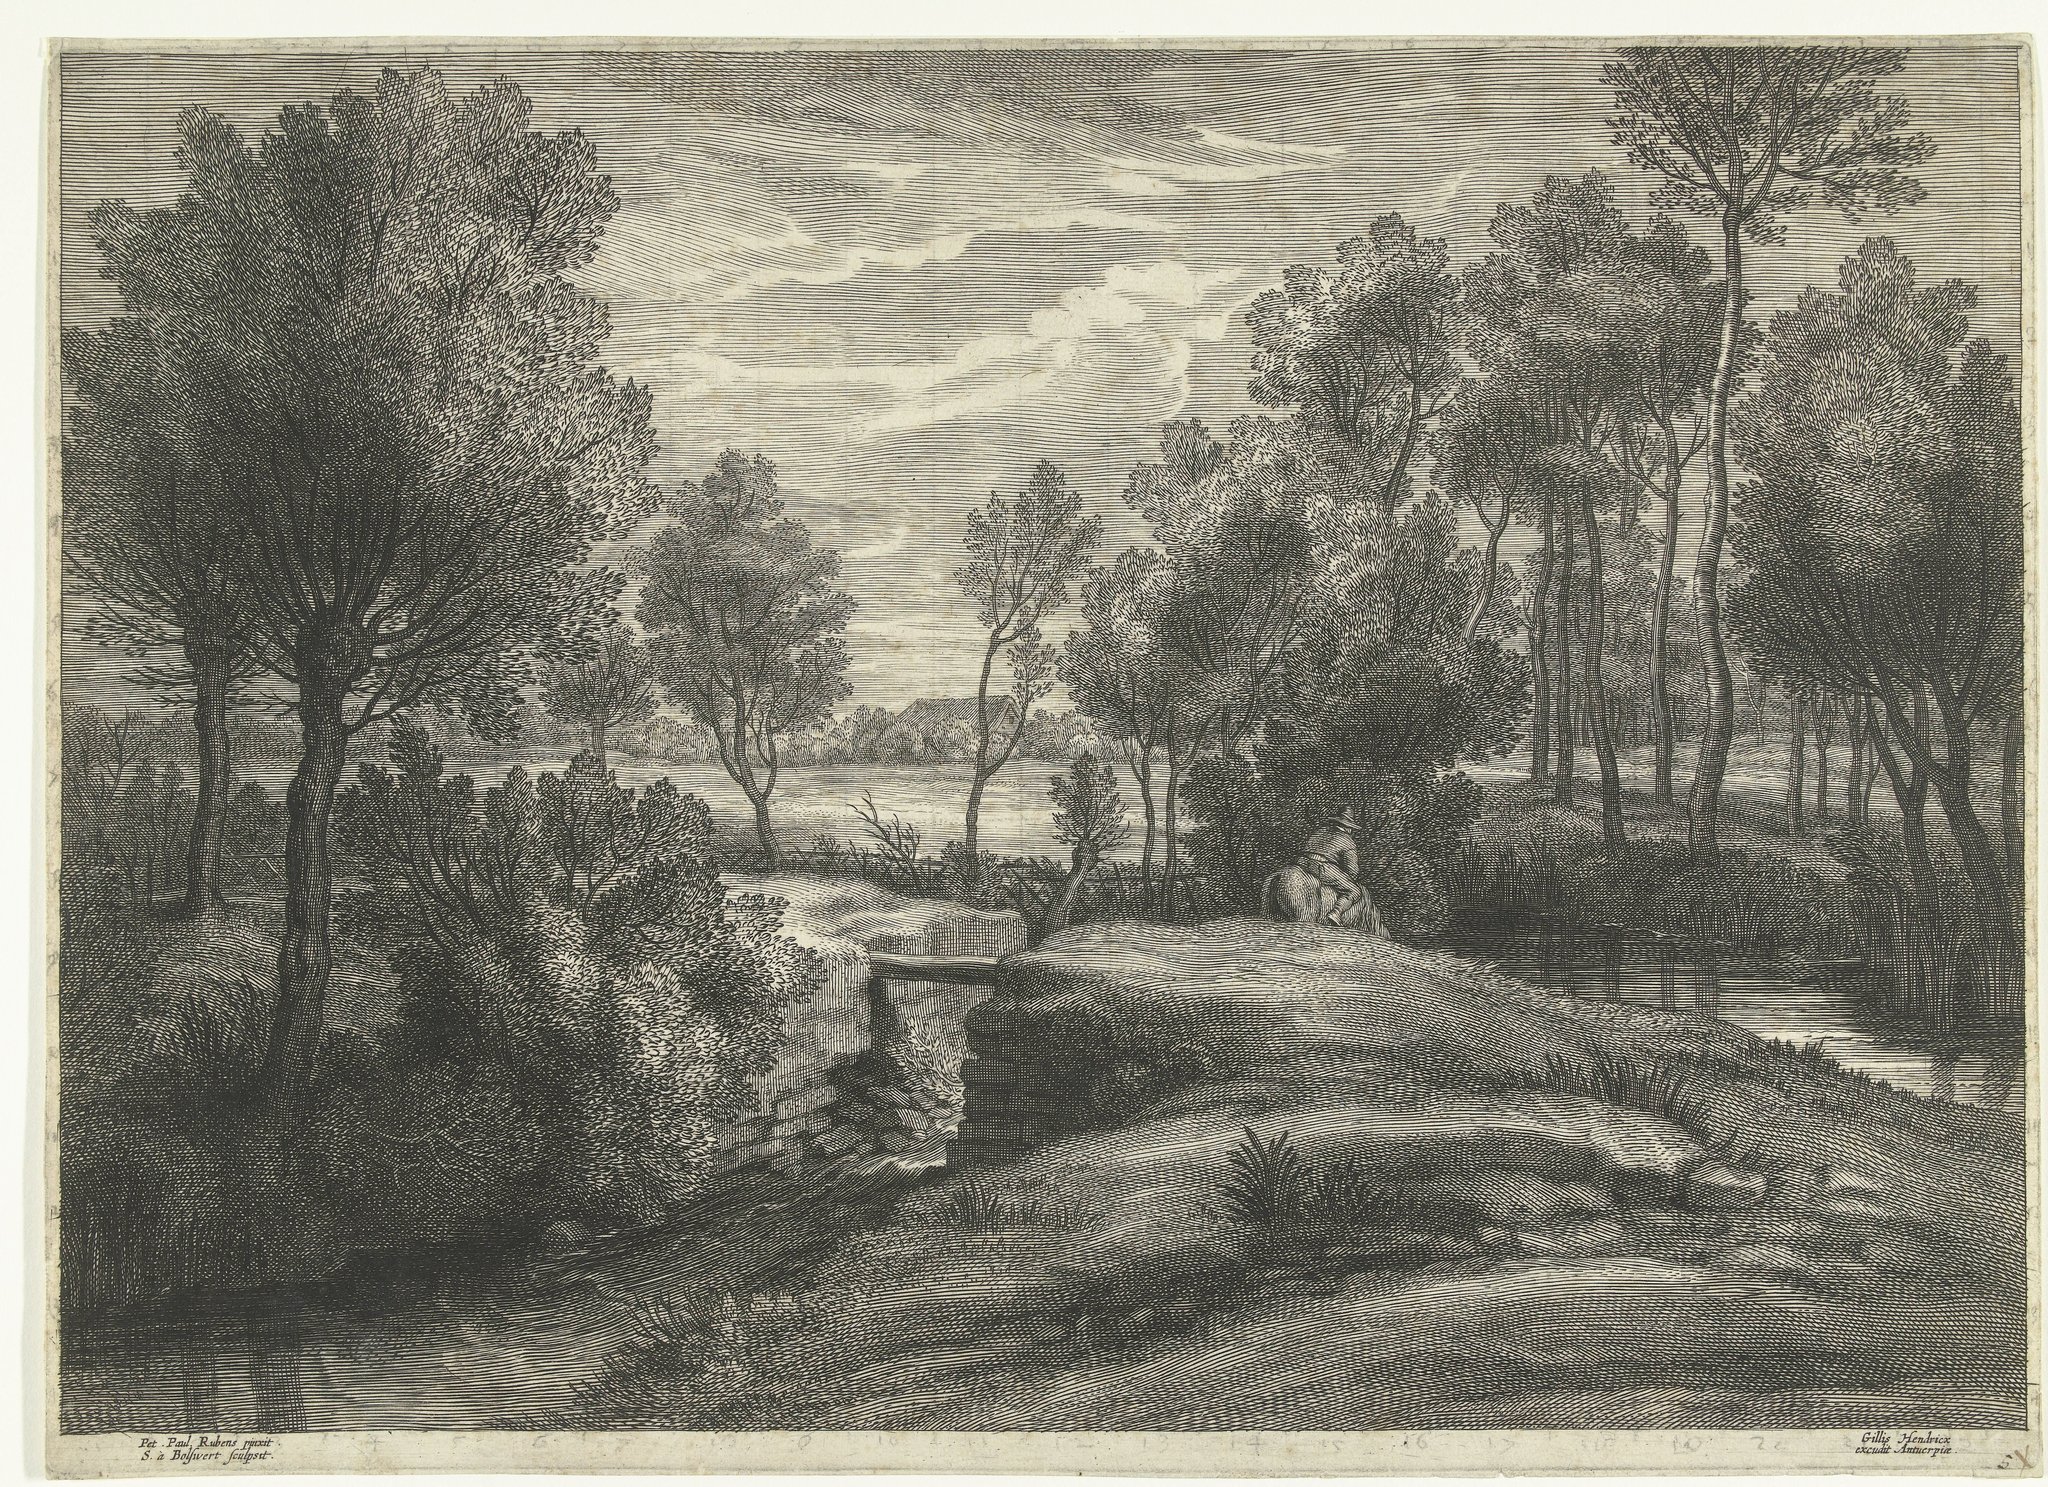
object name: print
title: Landschap met ruiter bij beek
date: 1596-1659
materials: paper, pencil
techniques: engraving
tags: brook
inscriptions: collector's mark: Lugt 10, collector's mark: Lugt 11, inscription: ‘B 29 - 39.58’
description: Prent naar schilderij van Peter Paul Rubens. Hollstein beschrijft een serie kleine landschappen onder de nrs. 305 t/m 325 maar deze prenten zijn niet als reeks vervaardigd.